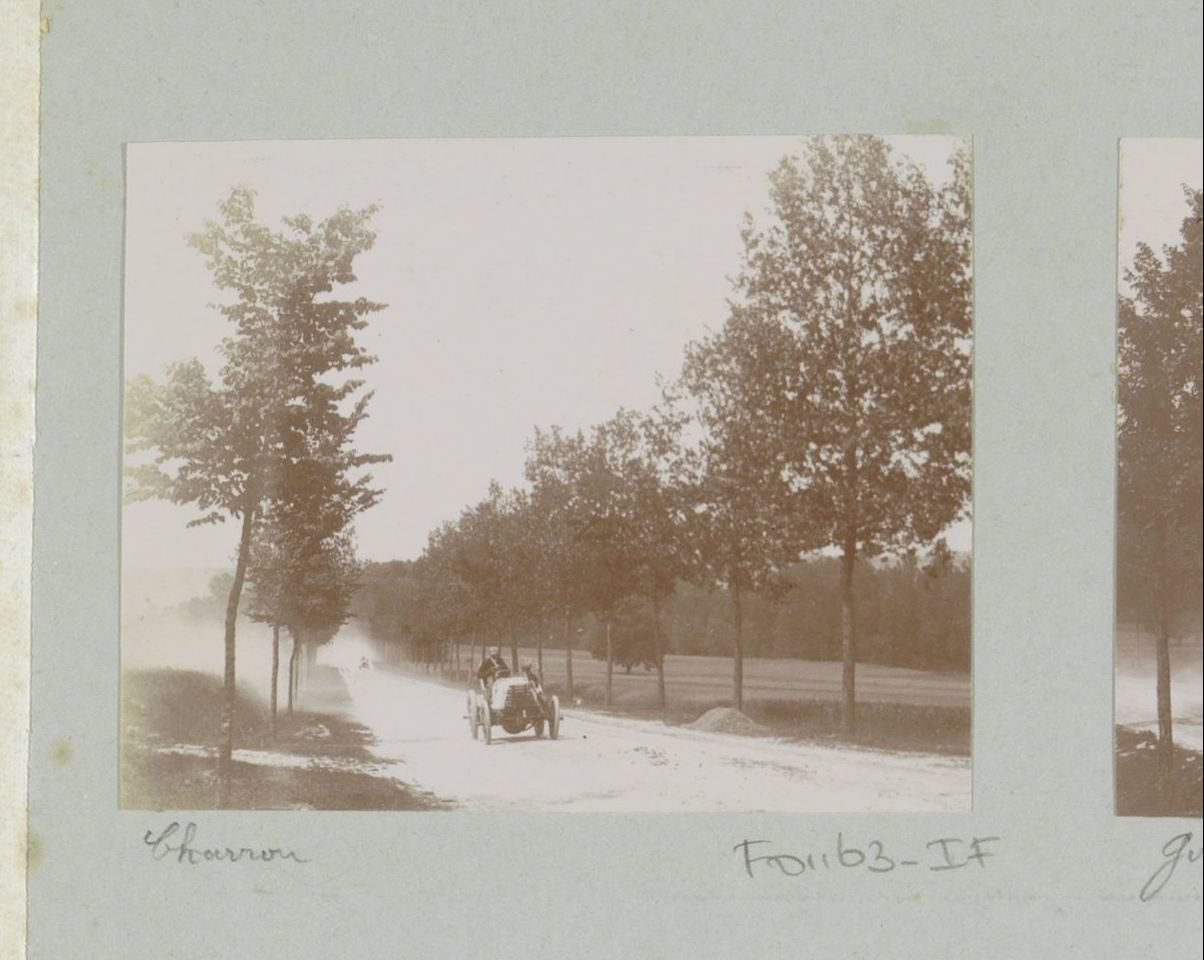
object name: photograph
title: Autocoureur Charron, deelnemer aan de Tour de France voor automobielen, op een landweg in Vitry-le-François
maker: delizy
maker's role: manufacturer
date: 1899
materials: paper, photographic support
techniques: gelatin silver print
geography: vitry-le-françois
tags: automobile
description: Onderdeel van Fotoalbum van een Franse amateurfotograaf met opnames van uitstapjes in Frankrijk, Spanje, België, Luxemburg en Nederland, de eerste automobielen en autoraces.